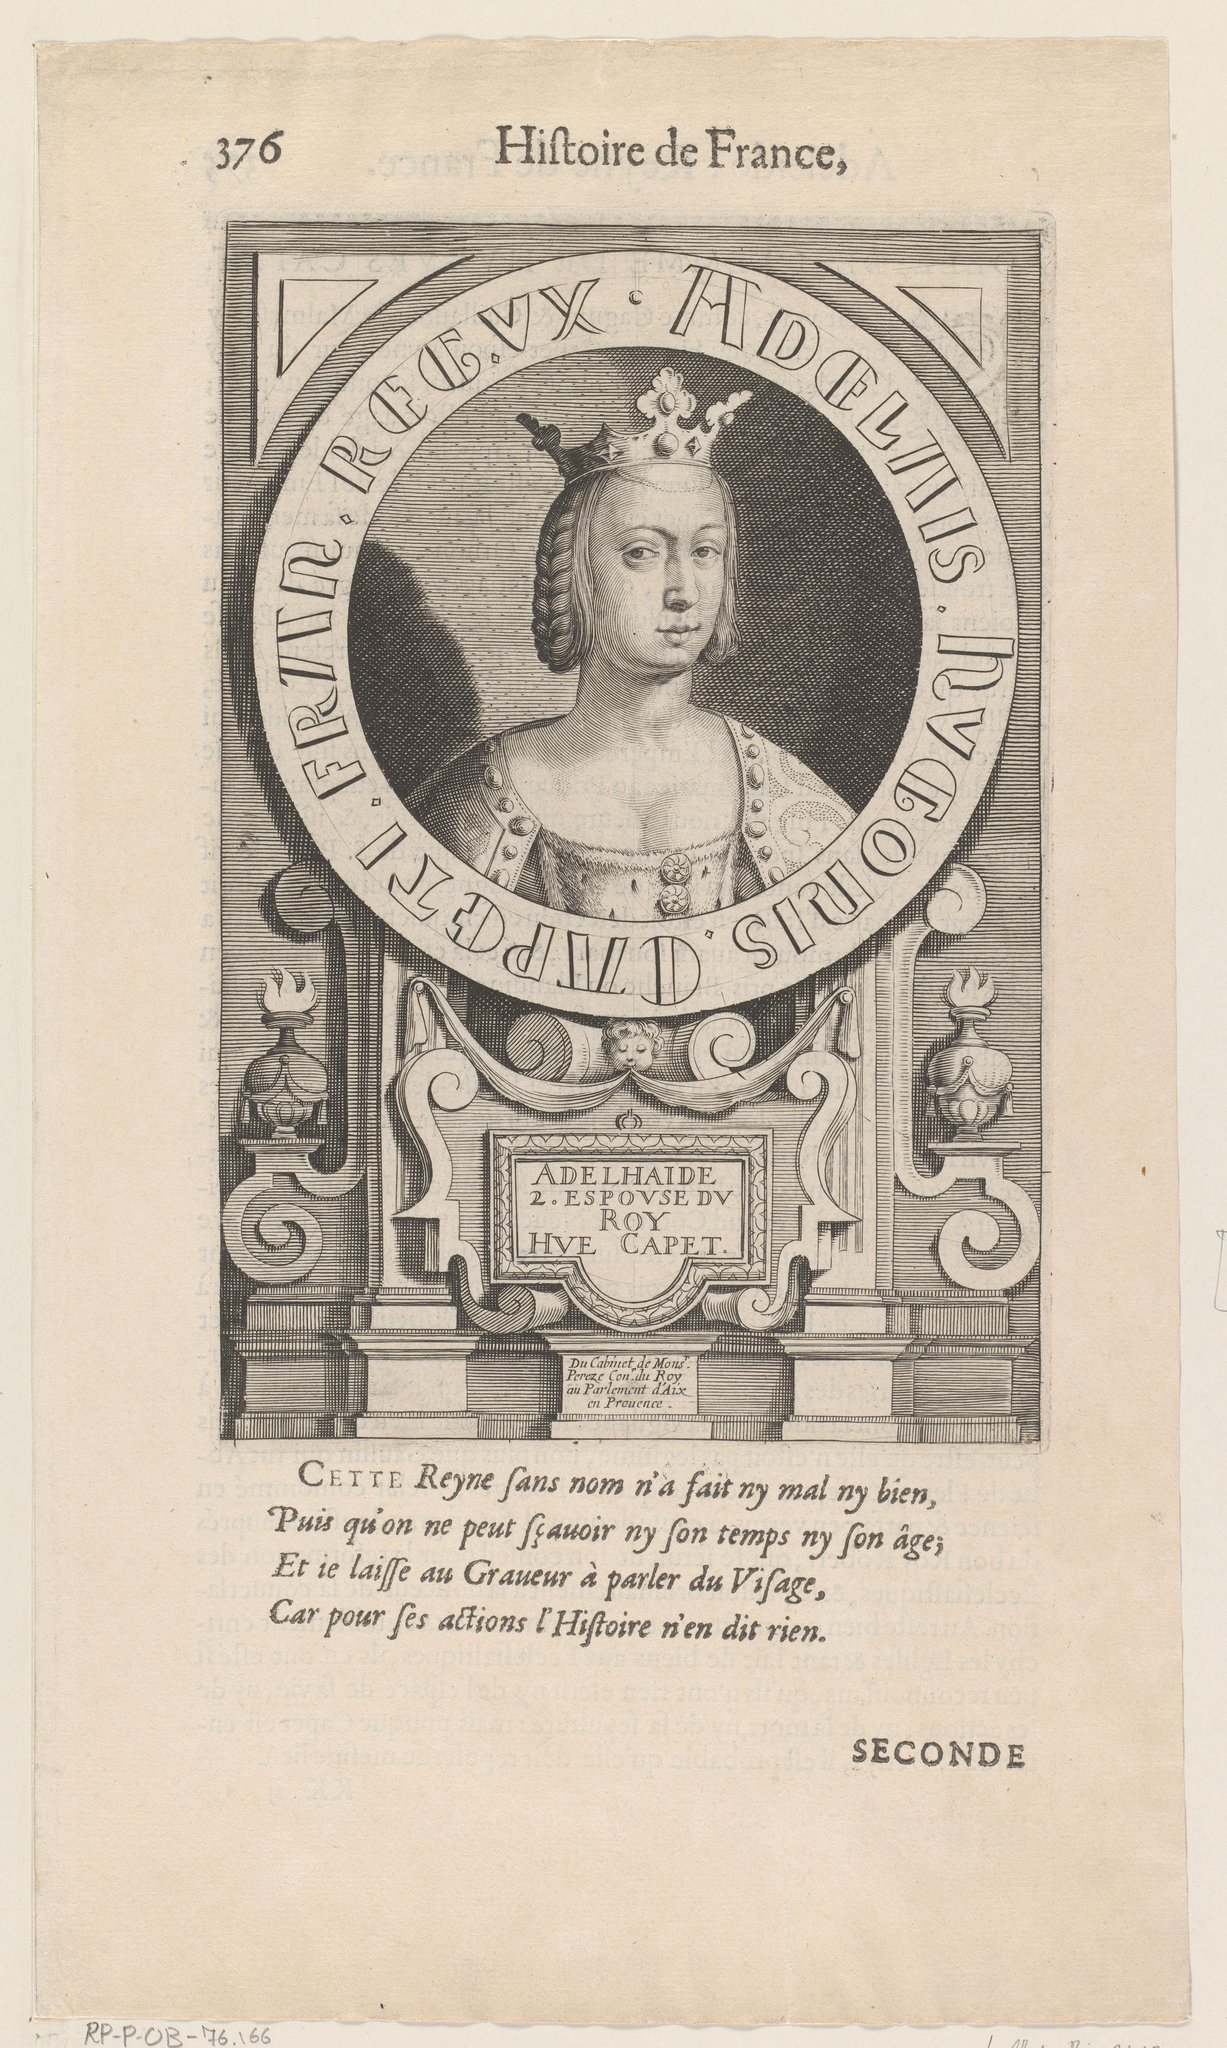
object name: book illustration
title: Portret van Adélaïde, prinses van Orleans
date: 1643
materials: paper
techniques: engraving, letterpress printing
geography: paris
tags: historical persons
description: Prent uit: Eudes de Mézeray, François. Histoire de France, depuis Faramond jusqu’au regne de Louis le Juste (...). 3 dln. Parijs: Mathieu Guillemot, 1643, dl. 1. Prent waarschijnlijk voor het eerst verschenen in: Bie, Jacques de. Les vrais portraits des rois de France (...). Parijs: Jacques de Bie en Pierre Rocolet, 1634. Prent ook gebruikt in latere publicaties.